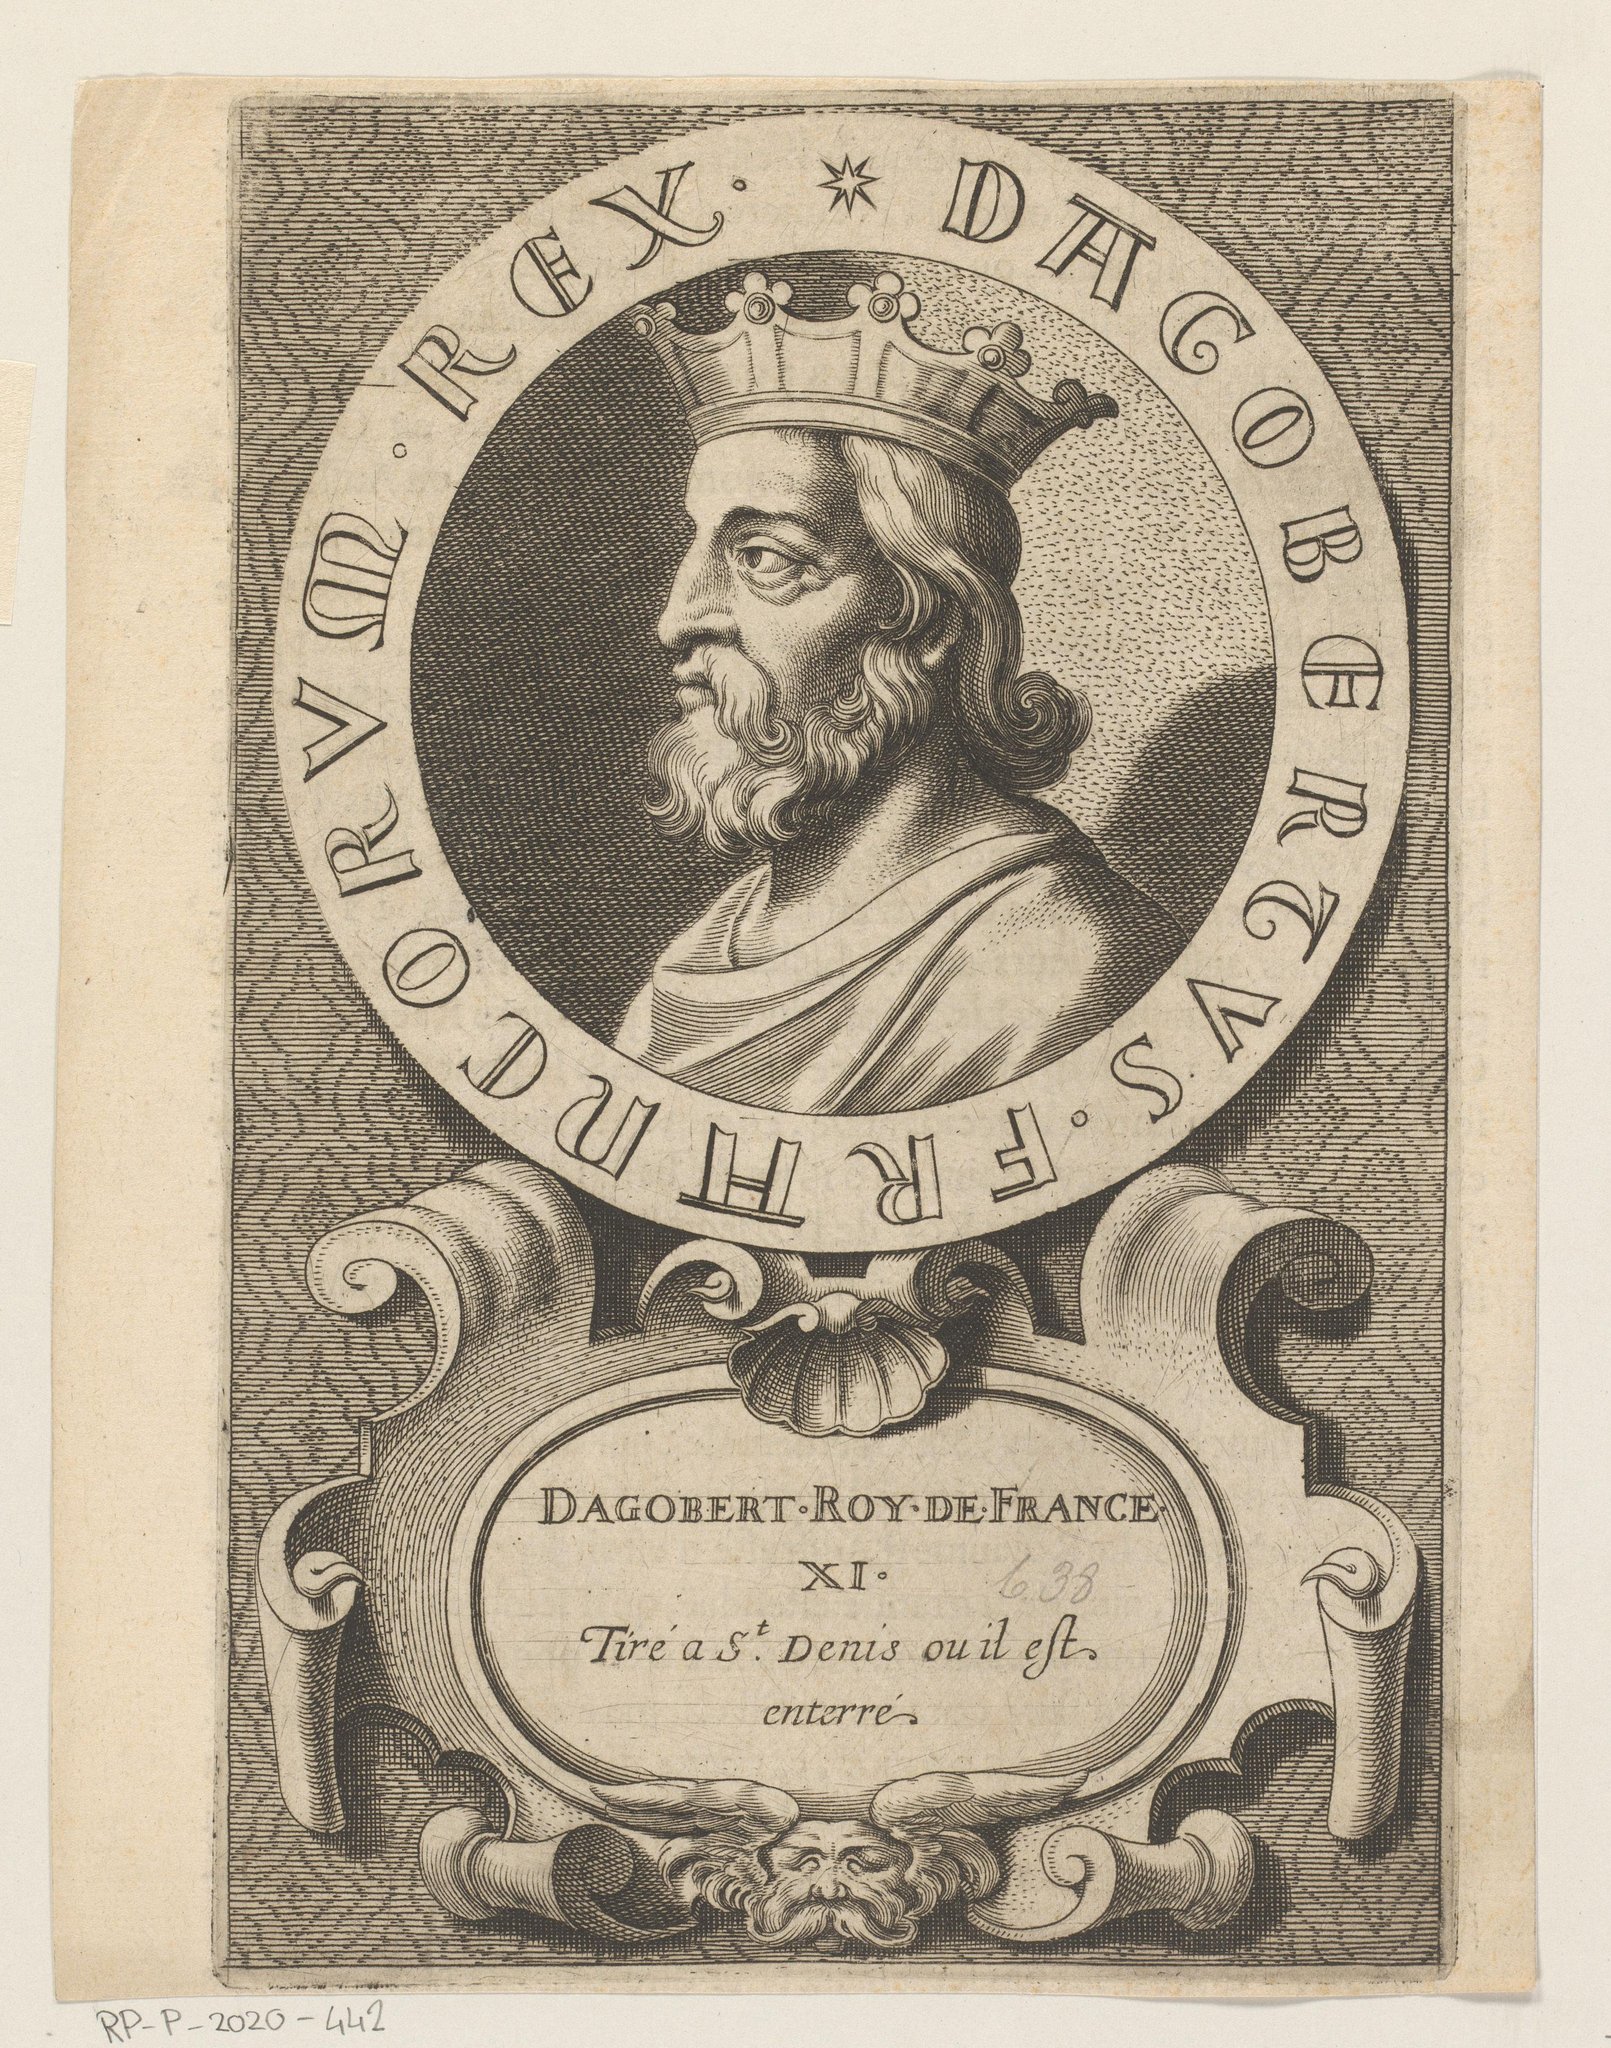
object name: print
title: Portret van Dagobert I, koning der Franken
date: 1636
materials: paper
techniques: engraving, letterpress printing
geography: paris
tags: historical persons, ruler, sovereign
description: Prent uit: Bie, Jacques de. Les vrais portraits des rois de France (...). Parijs: Jean Camusat, 1636. Prent ook gebruikt in latere publicaties.